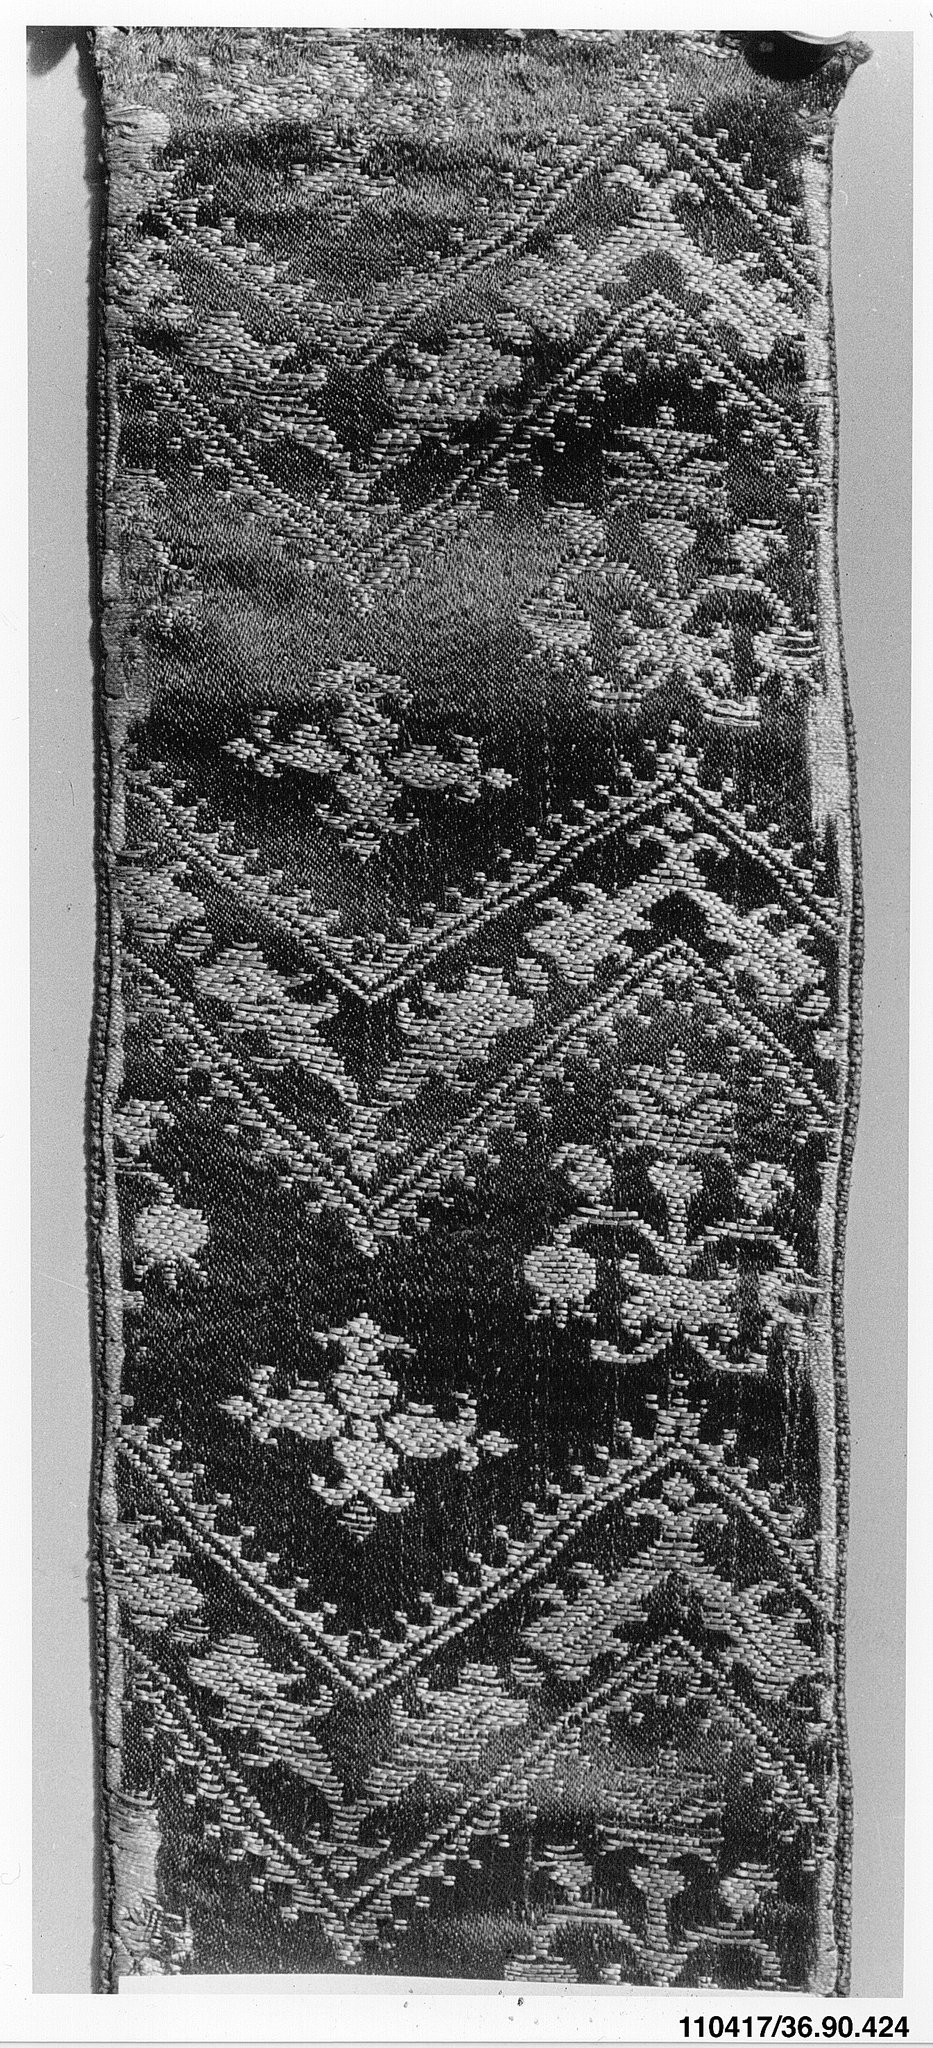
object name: piece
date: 1501-1700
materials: silk